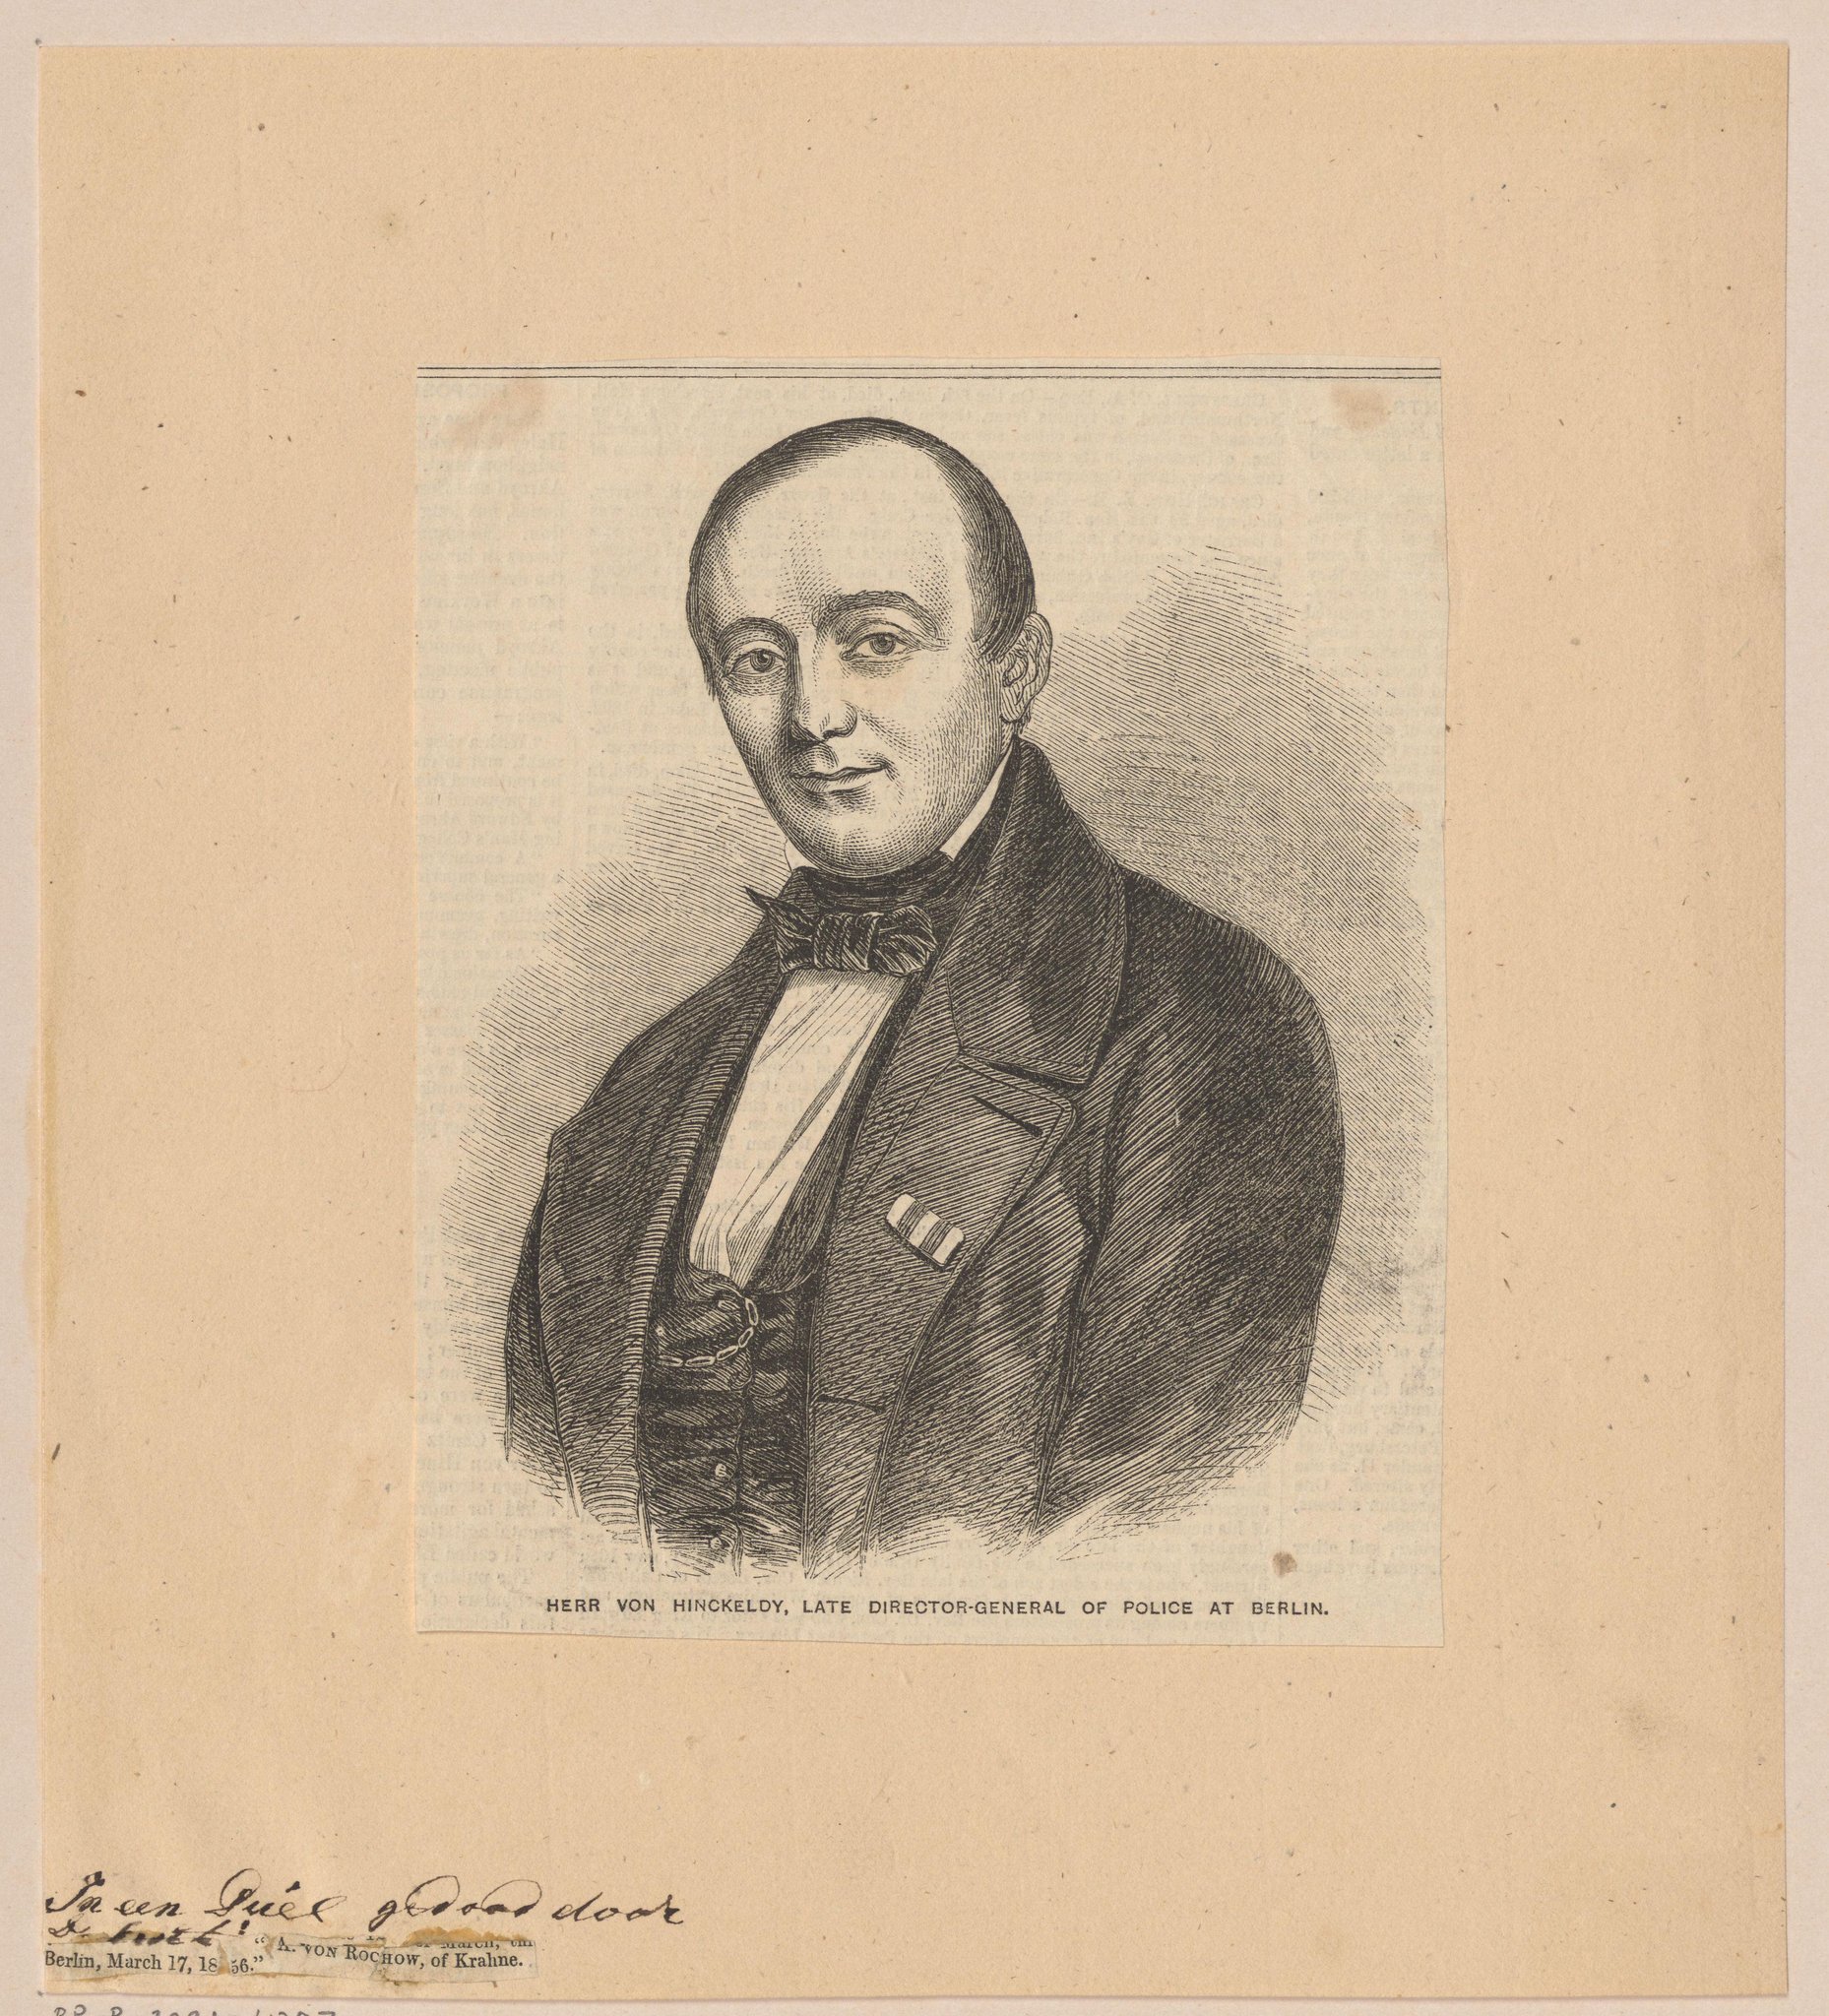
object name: print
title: Portret van Karl Ludwig Friedrich von Hinckeldey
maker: Anonymous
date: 1856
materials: paper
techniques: letterpress printing, engraving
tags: historical persons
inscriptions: inscription: ‘In een duel gedood door [...]’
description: Prent waarschijnlijk uit: The Illustrated London News.